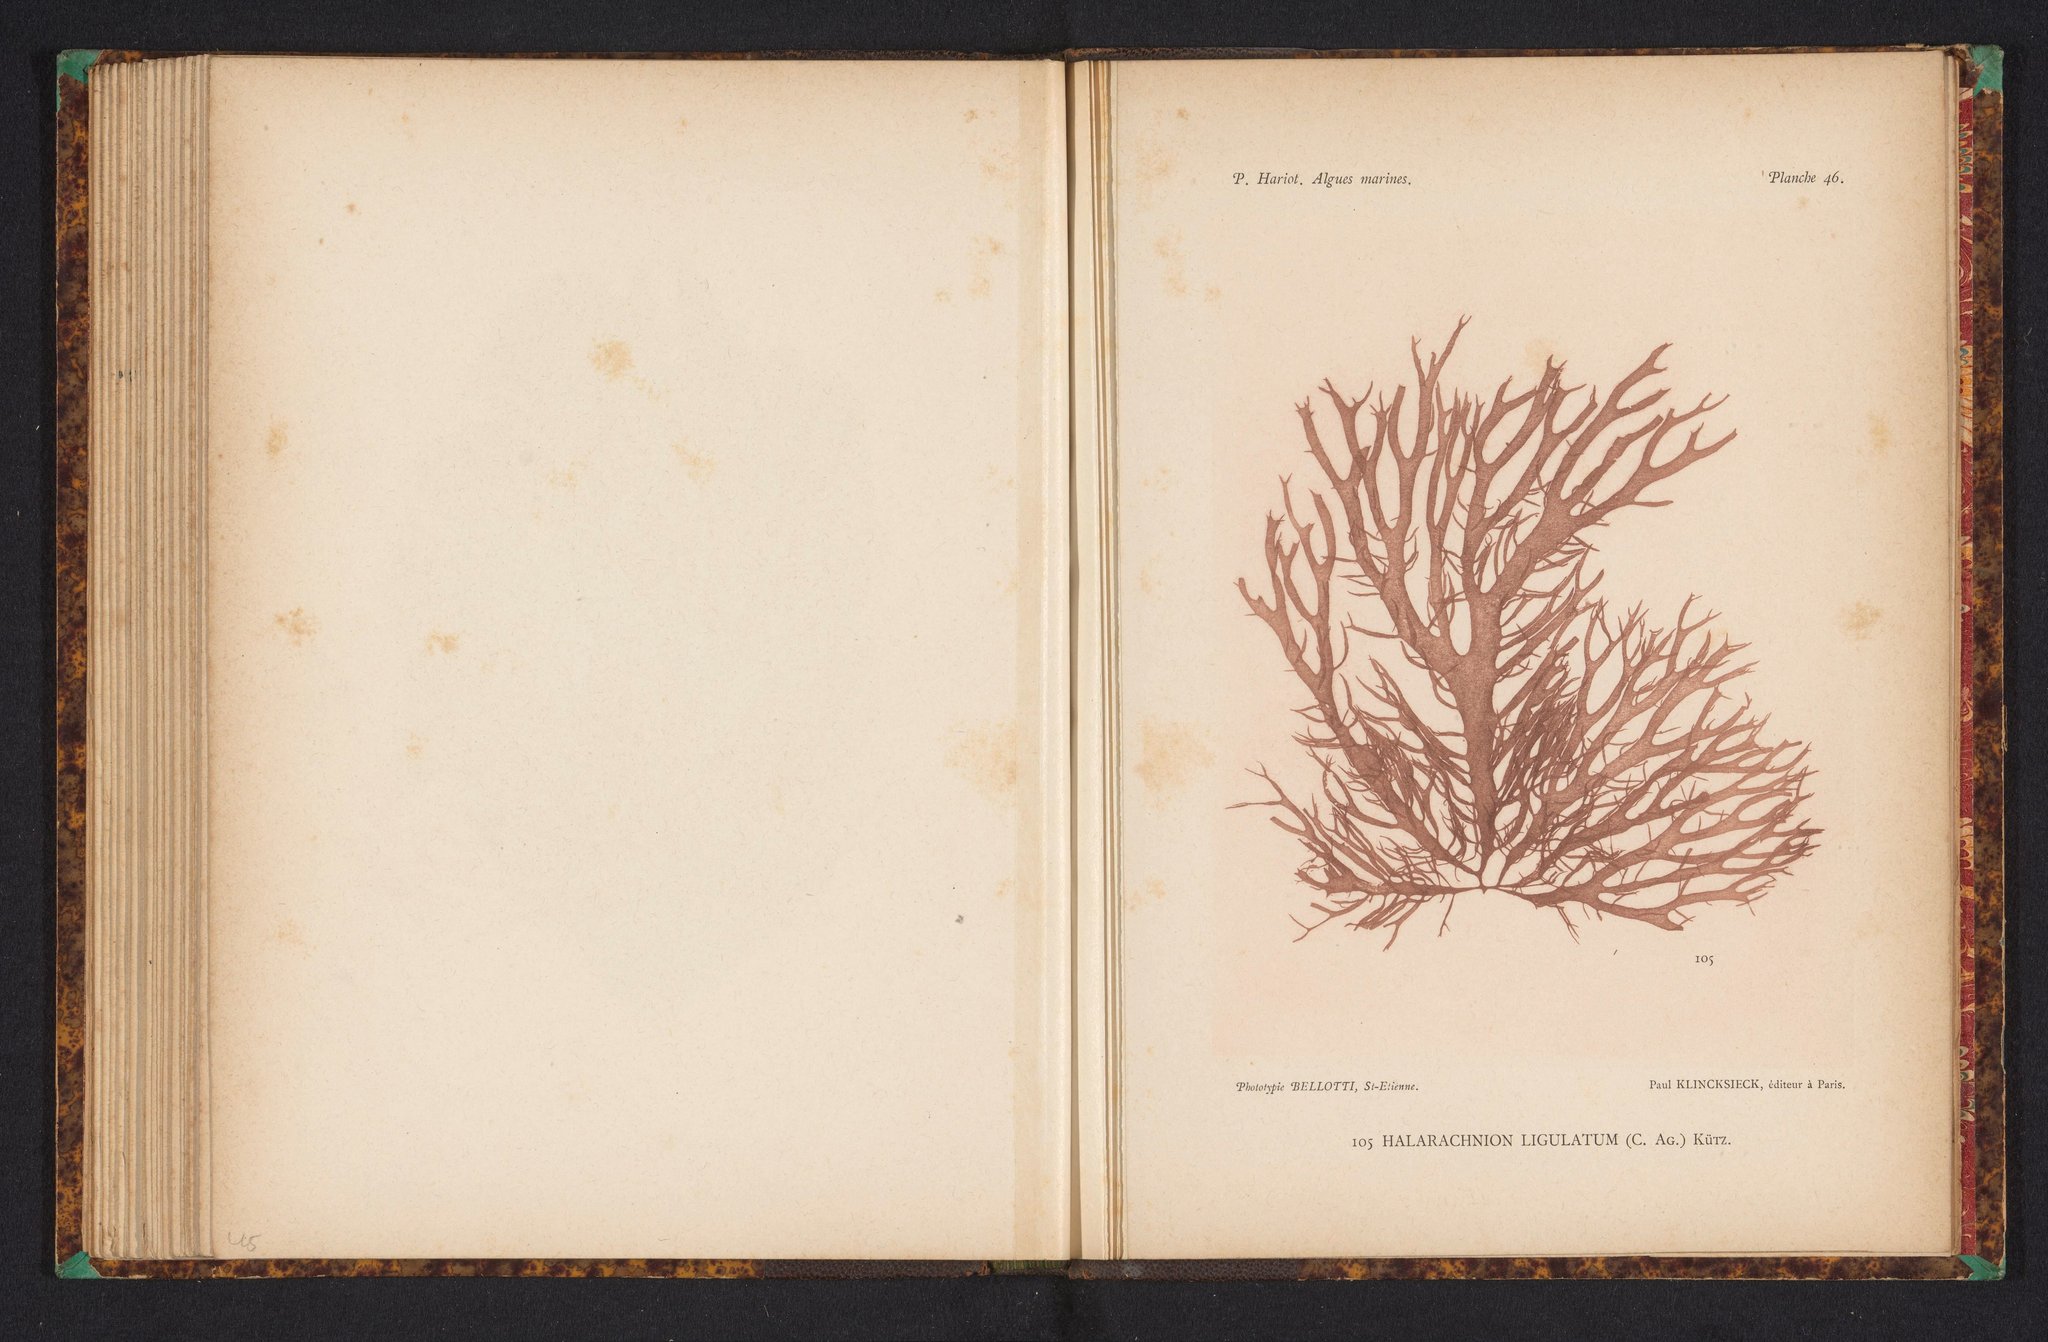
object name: page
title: Halarachnion ligulatum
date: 1882-1892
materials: paper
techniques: photograph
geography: paris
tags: algae, seaweed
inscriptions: number: ‘105’, number: ‘Planche 46.’, inscription: ‘Halarachnion ligulatum (C. Ag.) Kütz.’